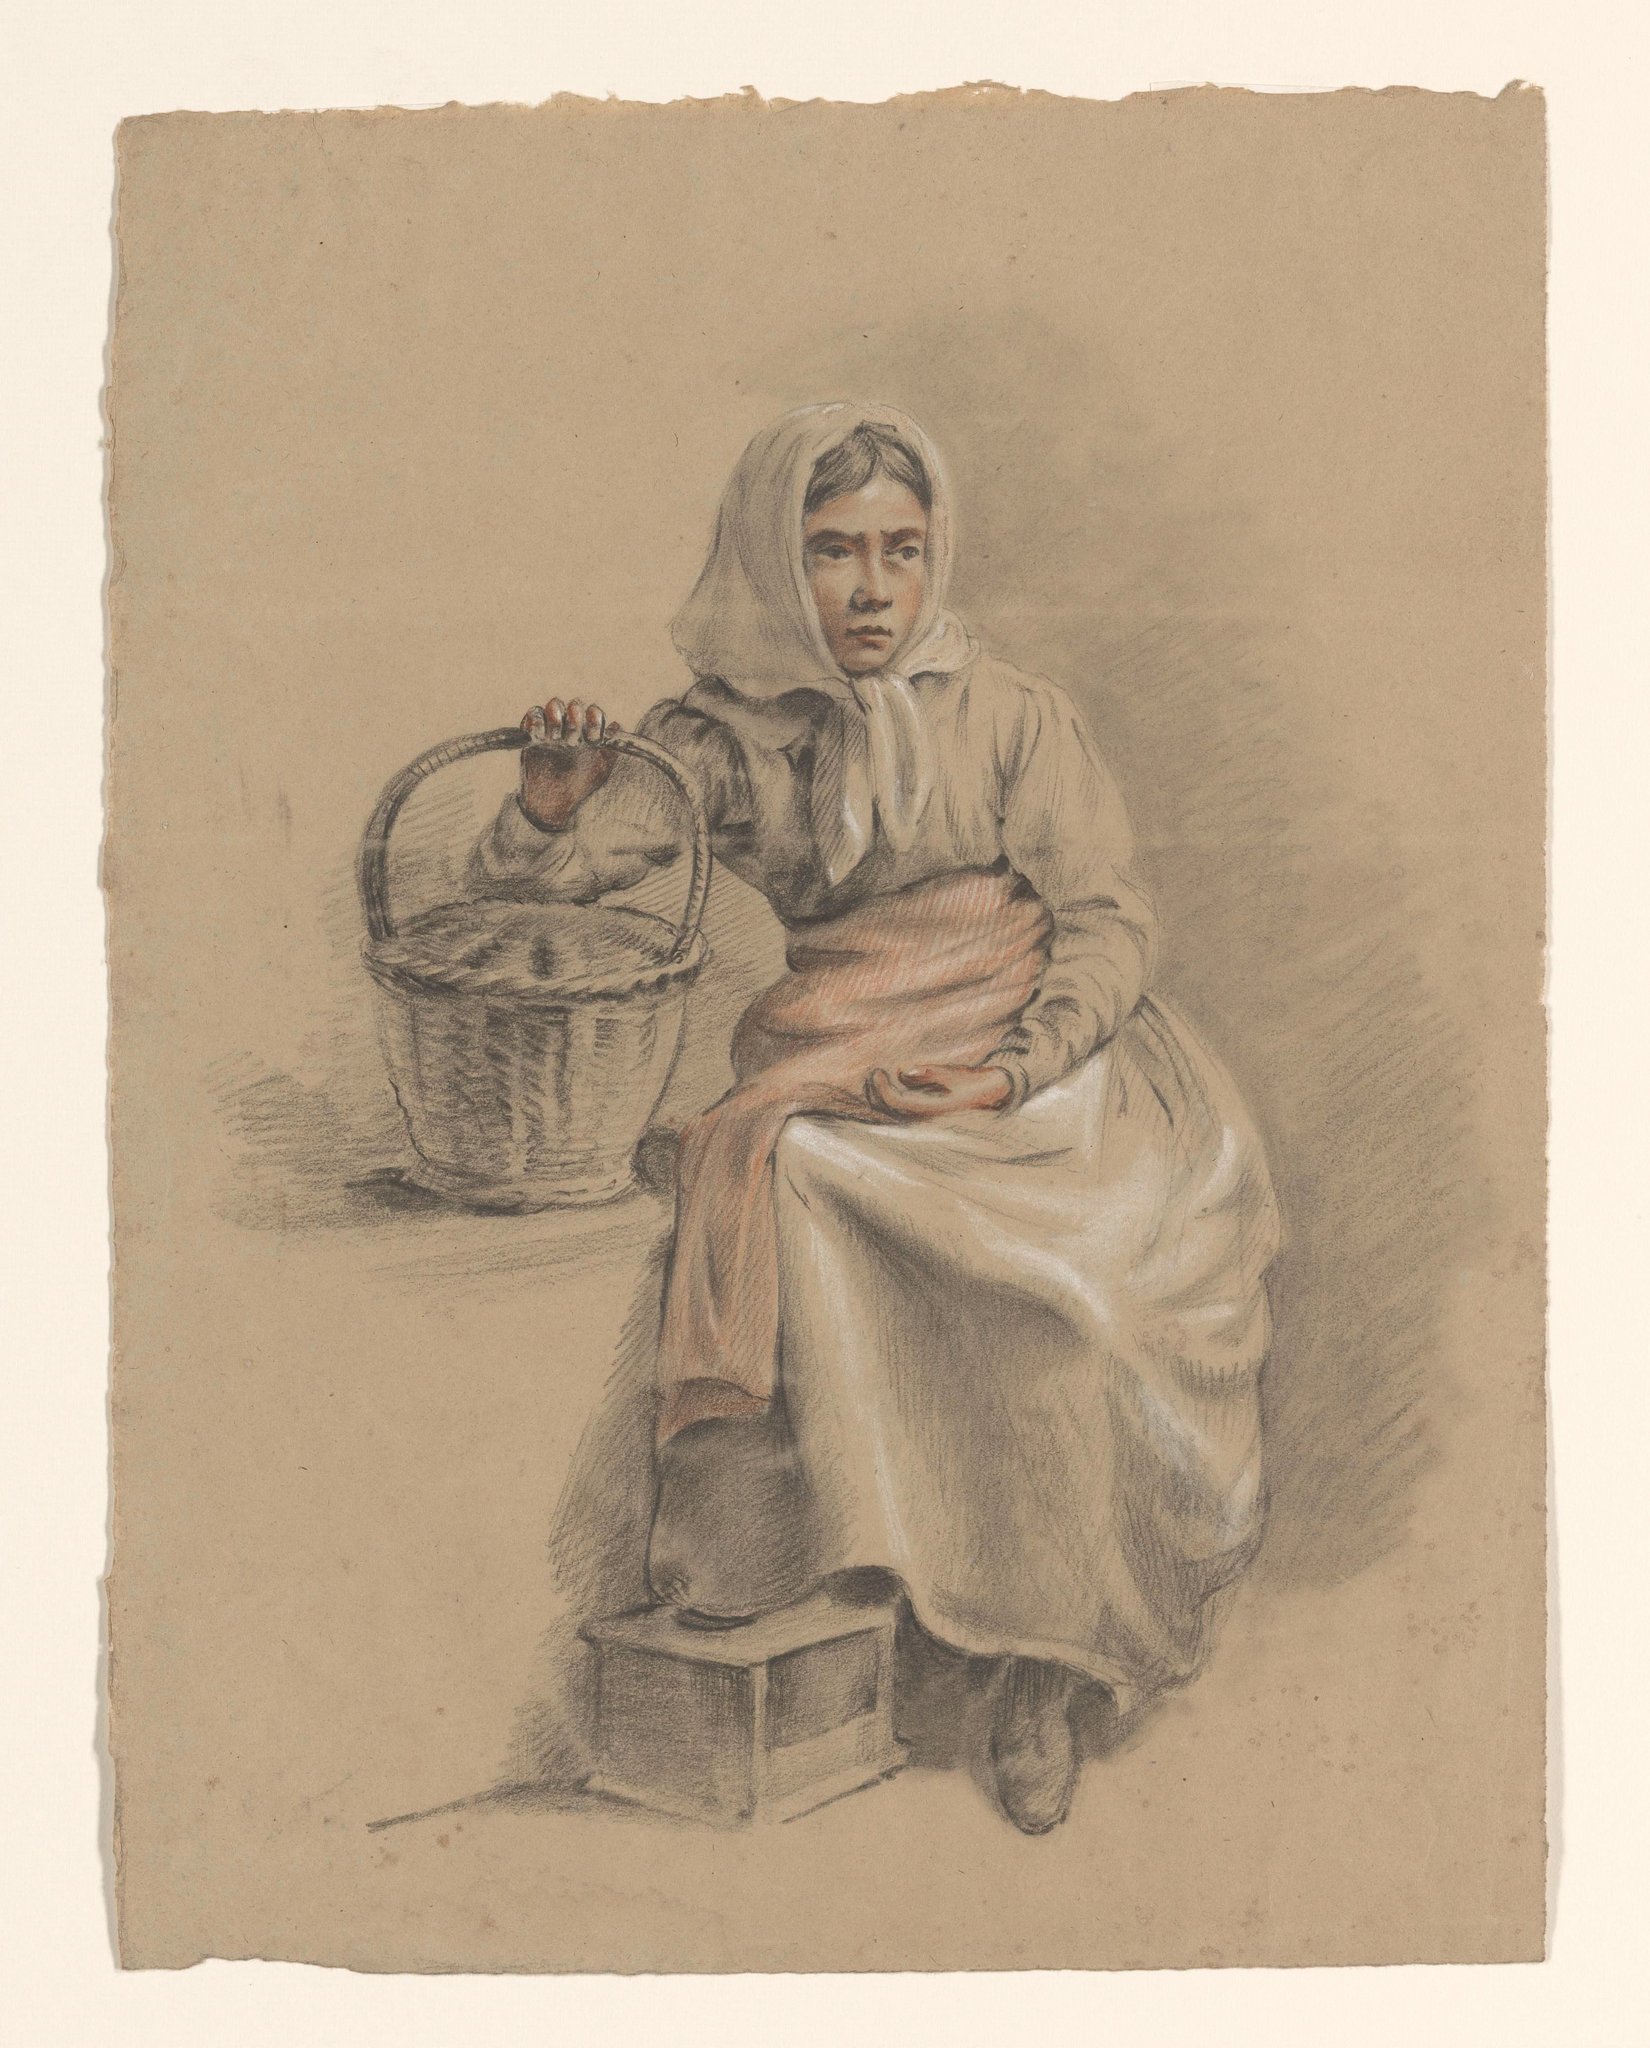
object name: drawing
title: Zittende vrouw met mand, de voet op een stoof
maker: alexander cranendoncq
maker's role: draughtsman, print maker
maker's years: 1799-1869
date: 1809-1869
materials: chalk, paper